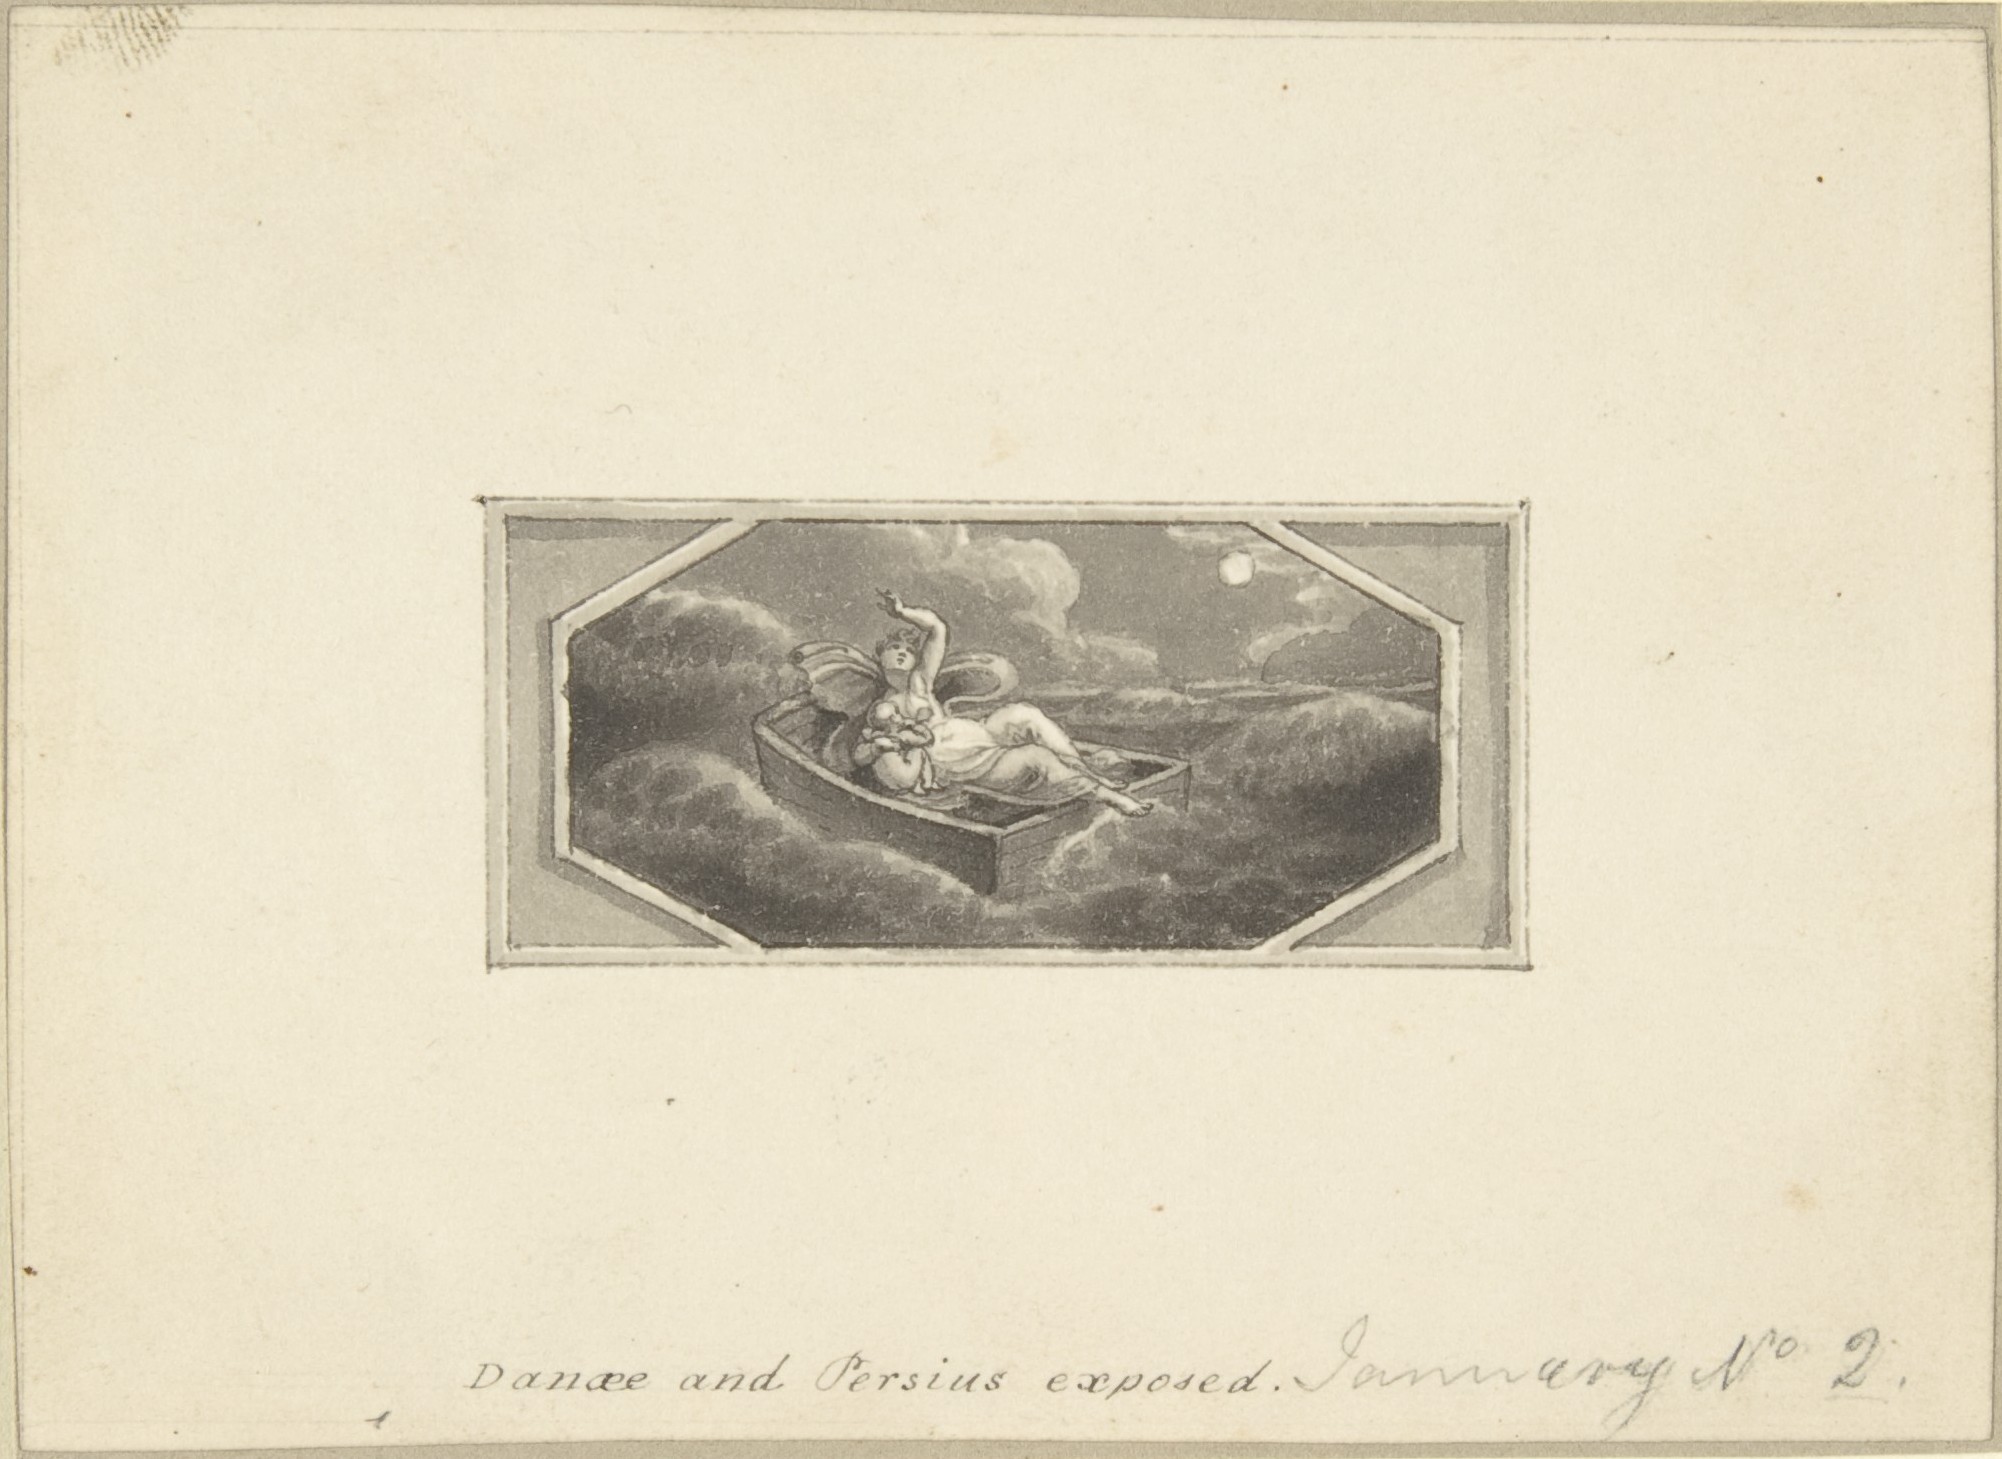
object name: drawing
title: Danae and Perseus Exposed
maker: edward francis burney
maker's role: artist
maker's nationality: british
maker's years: 1760-1848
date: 1790-1800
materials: ink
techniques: brush, pen, wash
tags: perseus